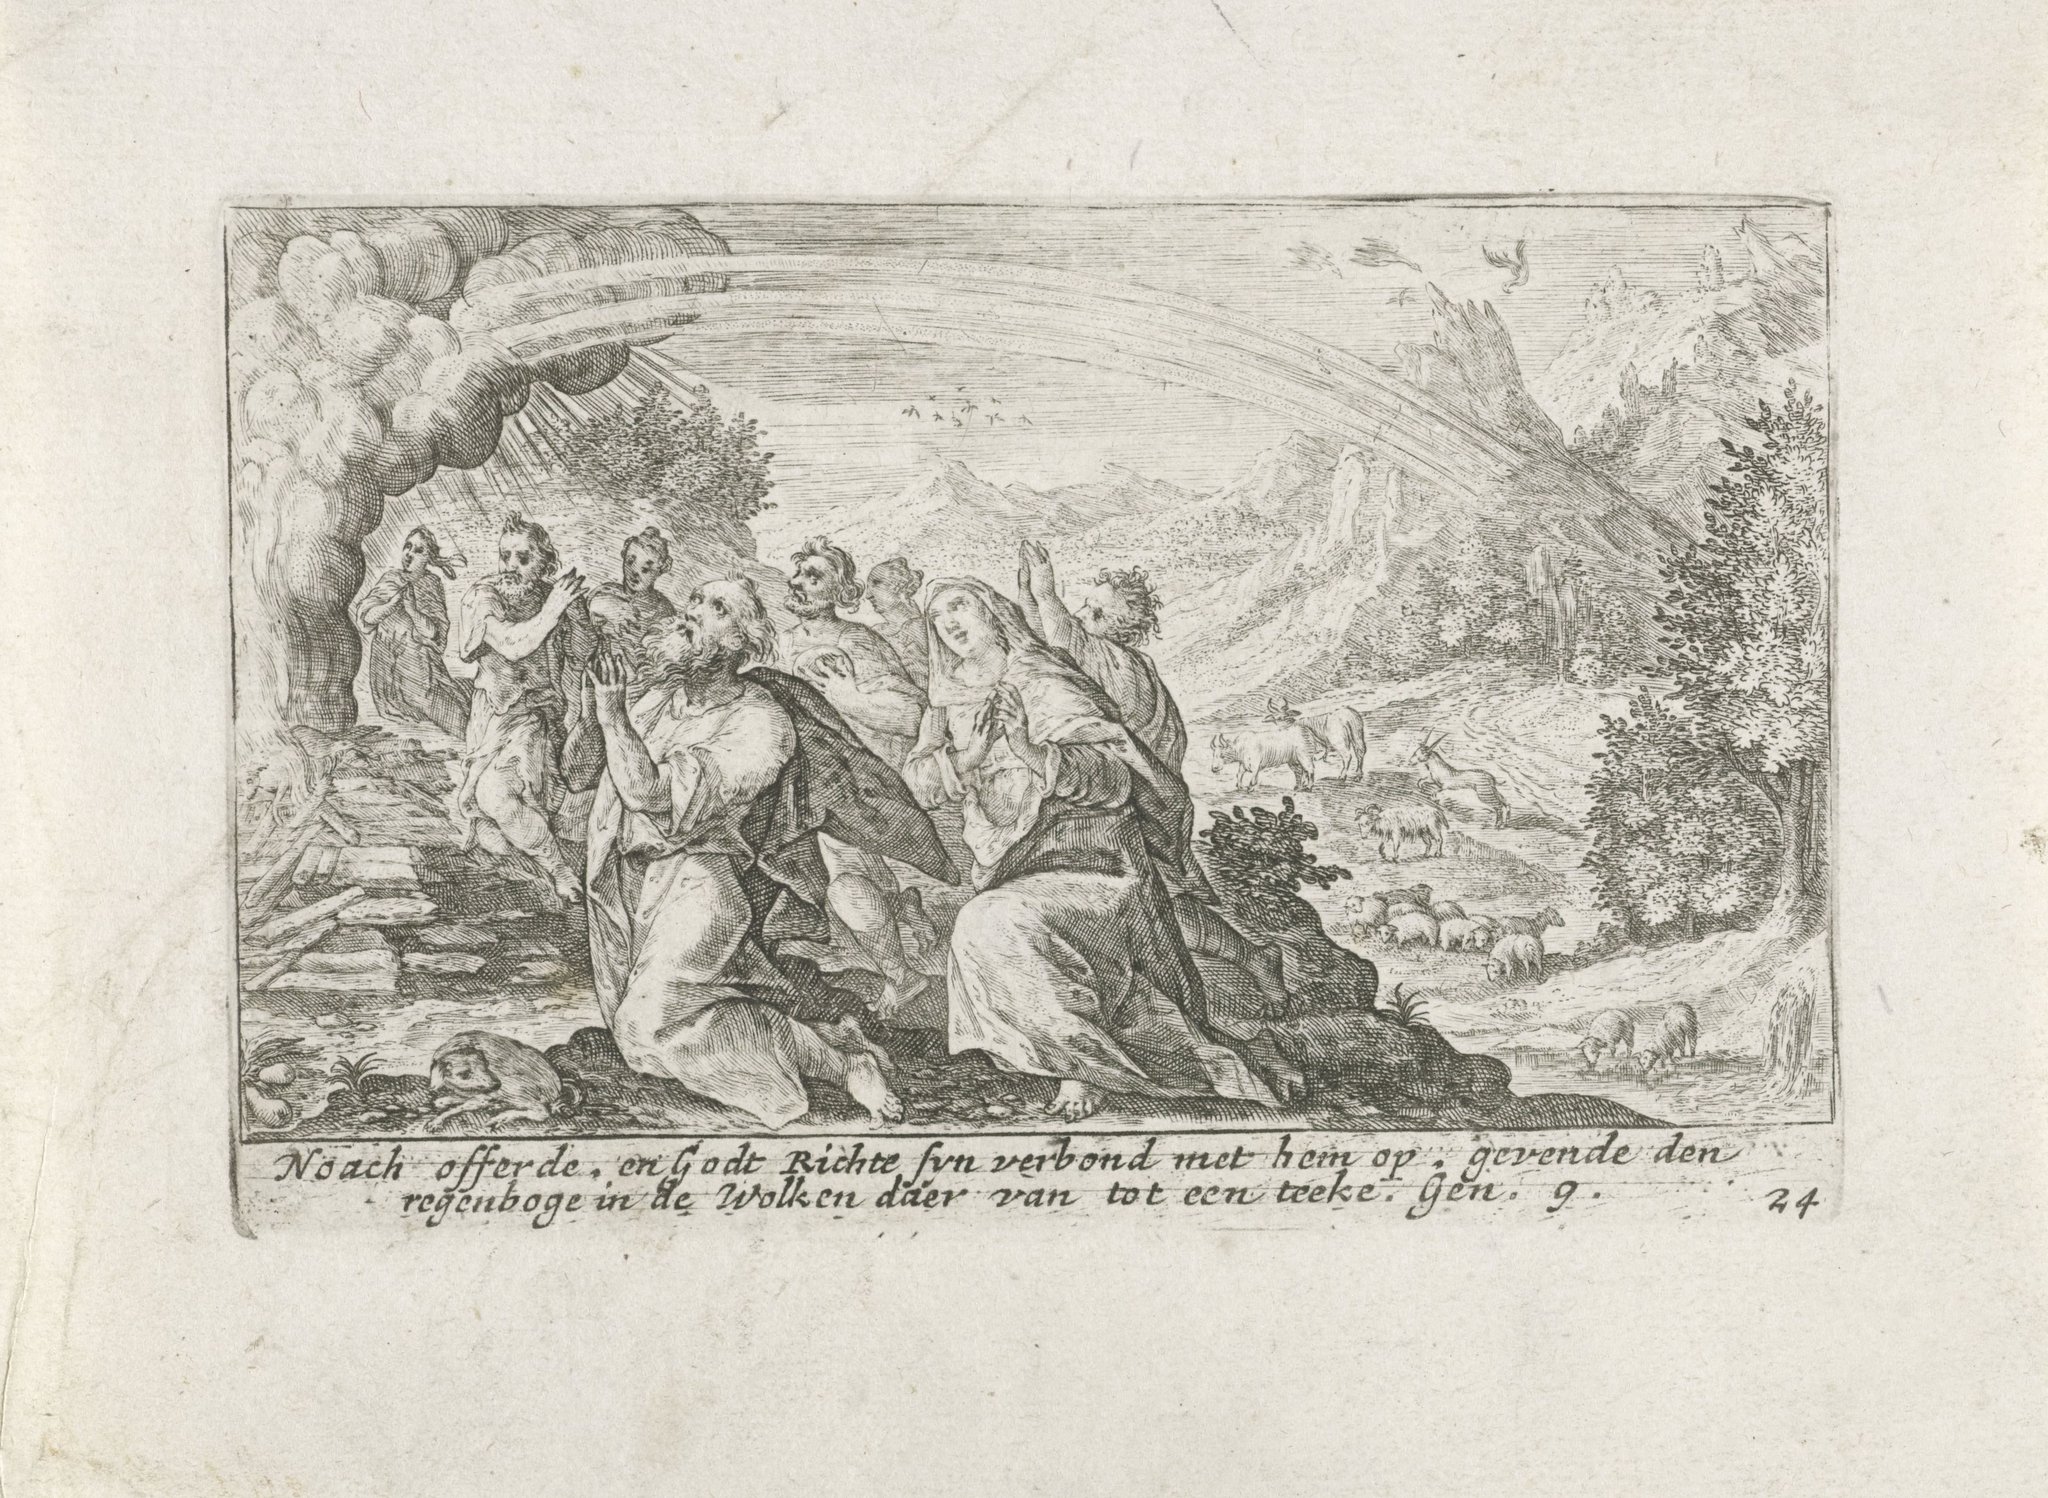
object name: print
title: Liber Genesis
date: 1700-1750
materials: paper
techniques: engraving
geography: amsterdam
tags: noah's sacrifice; various animals are offered, possibly a lamb, a dove and a ram (often combined with the rainbow of the covenant)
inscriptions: collector's mark: Lugt 2233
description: Noach en zijn gezin knielen voor het altaar, waar zij een lam offeren. Vol ontzag kijken ze naar de hemel waar een regenboog verschijnt, als teken van het verbond. In de marge een tweeregelig onderschrift in het Nederlands.